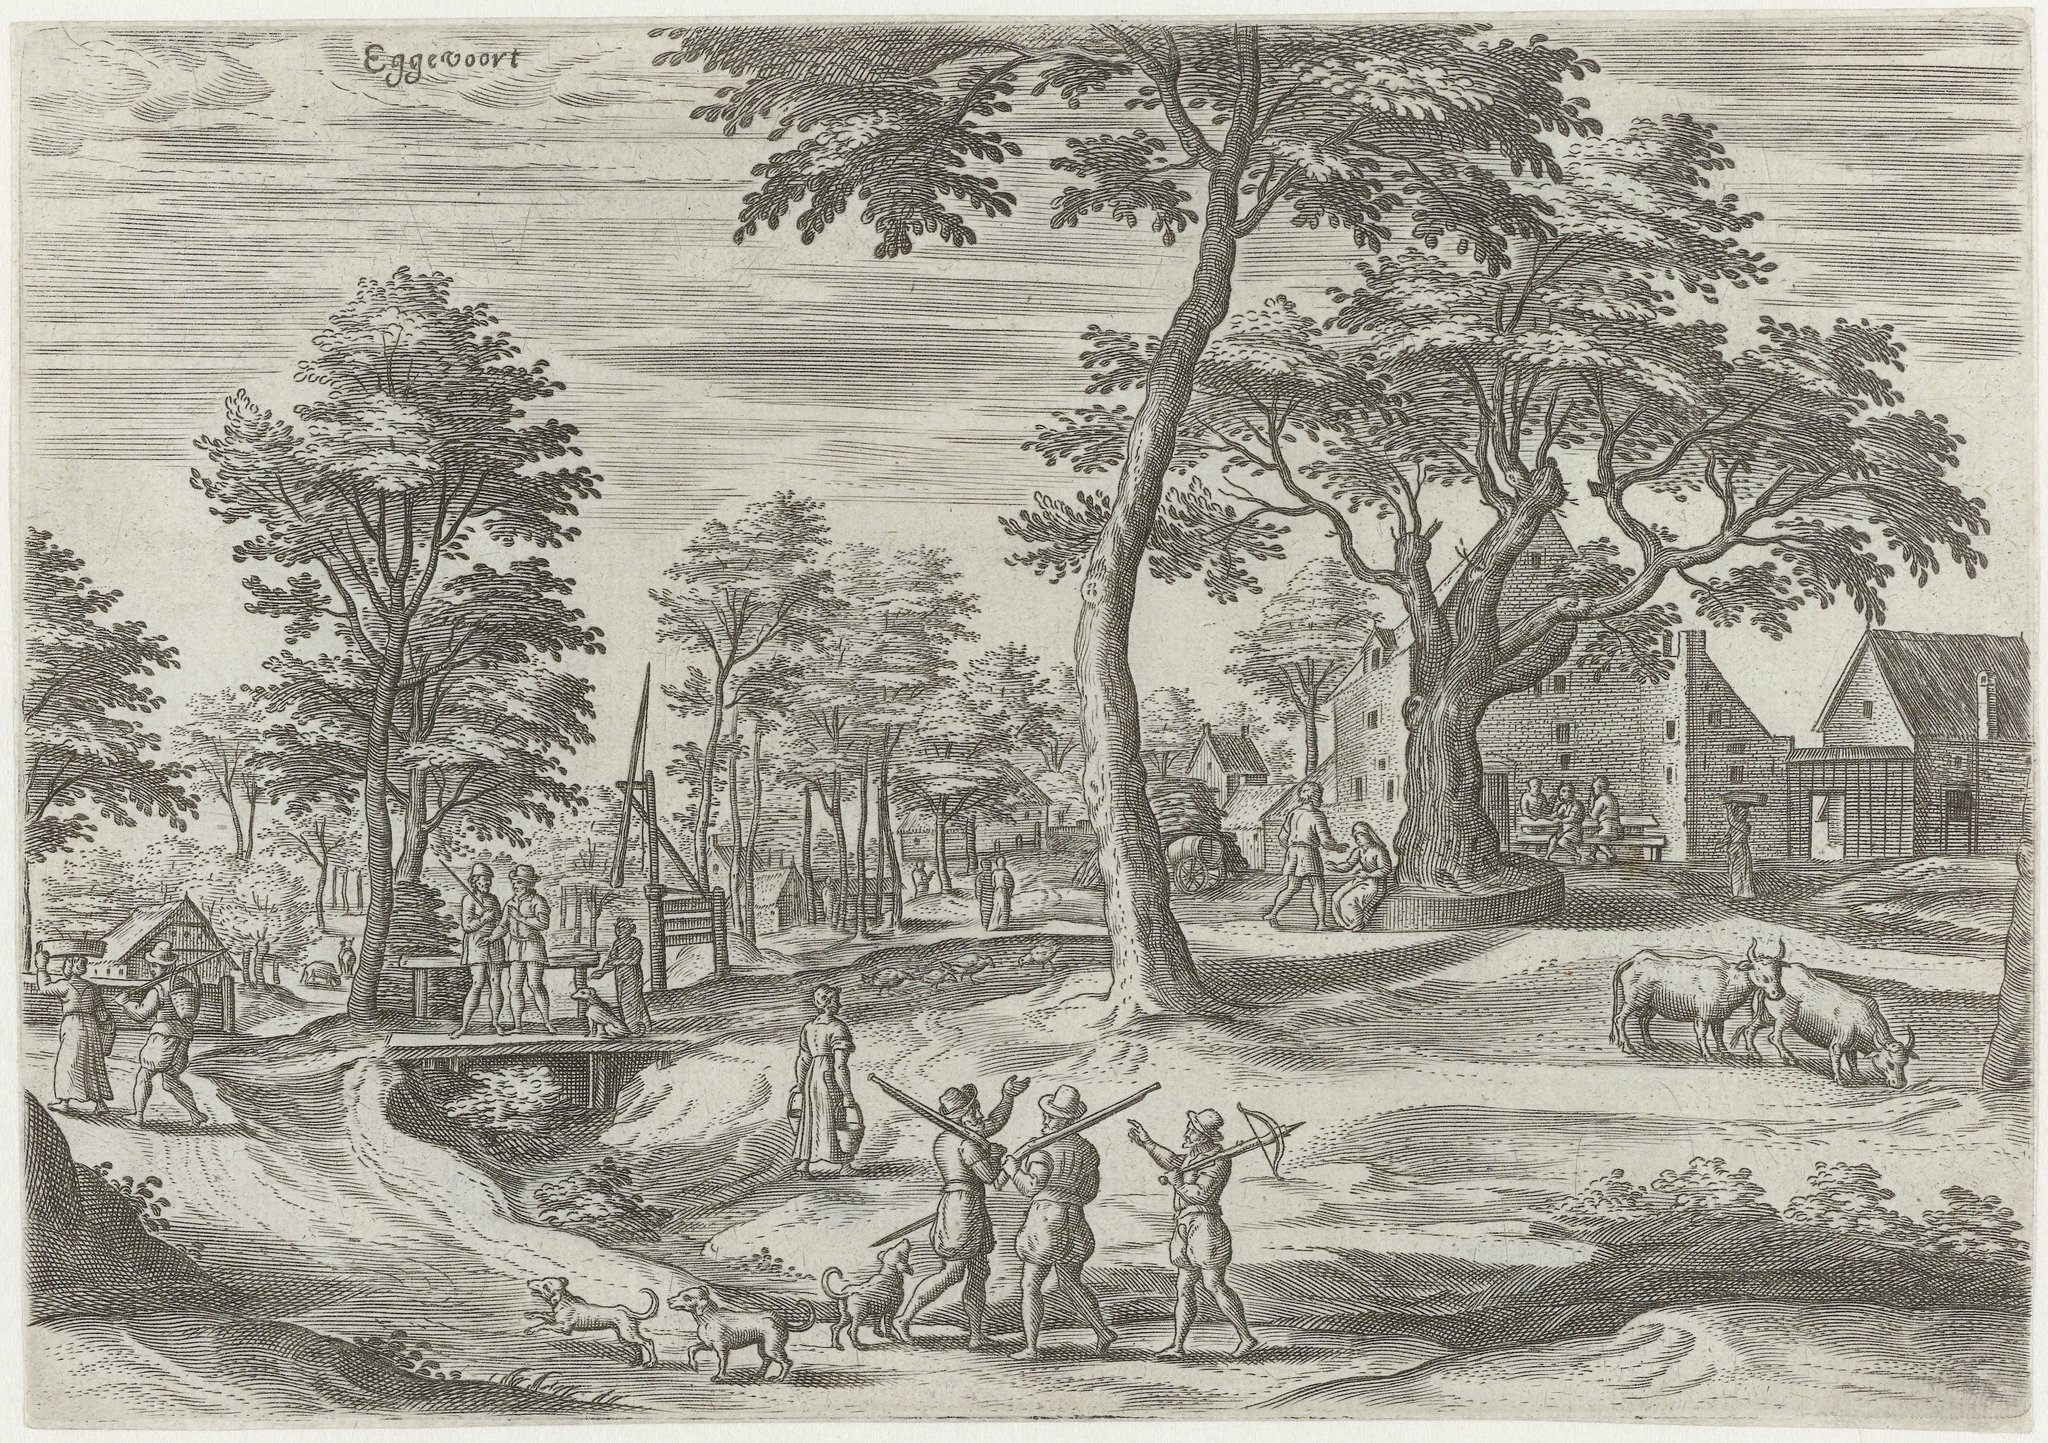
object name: print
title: Gezicht op Eggevoort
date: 1555-1576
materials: paper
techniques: engraving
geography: antwerp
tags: hunter, hotel, hostelry, inn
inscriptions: collector's mark: ‘Sammlung J.E. Wetterauer’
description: Elfde prent uit een serie van vierentwintig gezichten in de omgeving van Brussel. Op de voorgrond jagers, op de achtergrond een herberg.